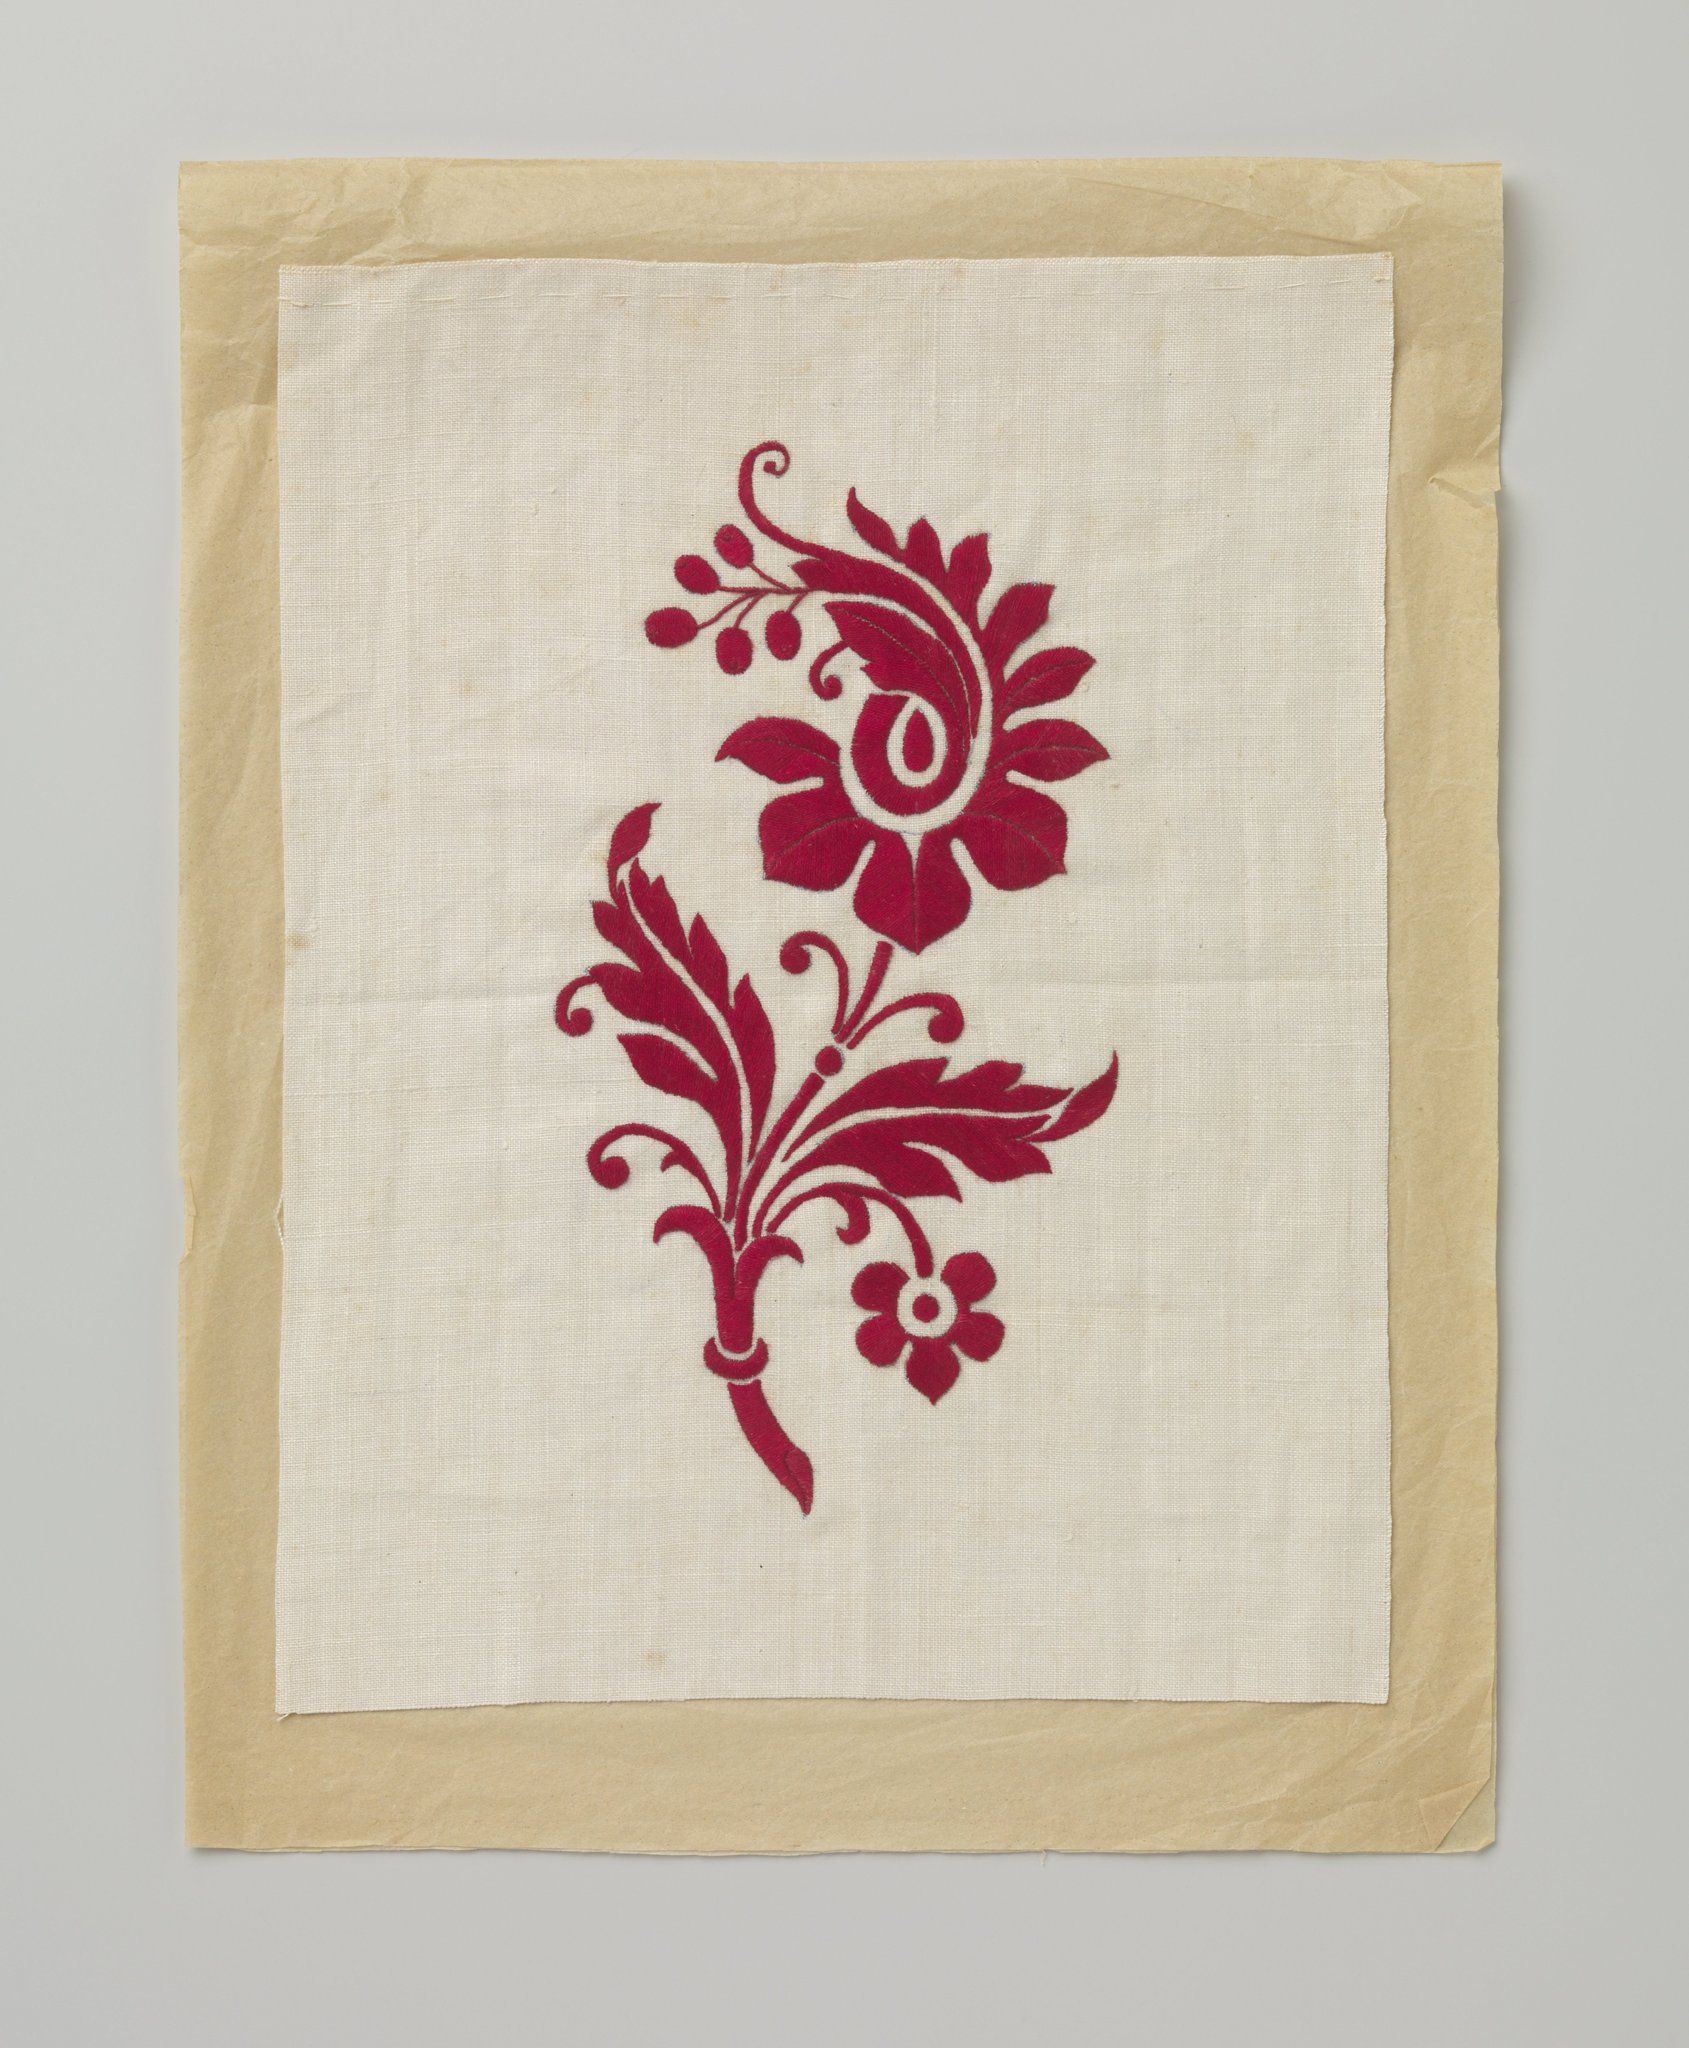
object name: werkstuk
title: Werkstuk voor Diploma fraaie handwerken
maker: geesje smid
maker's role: artisan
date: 1890-1900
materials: cotton, textile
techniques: embroidered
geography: netherlands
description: Linnen met bloemtak geborduurd in rood met satijnsteek.